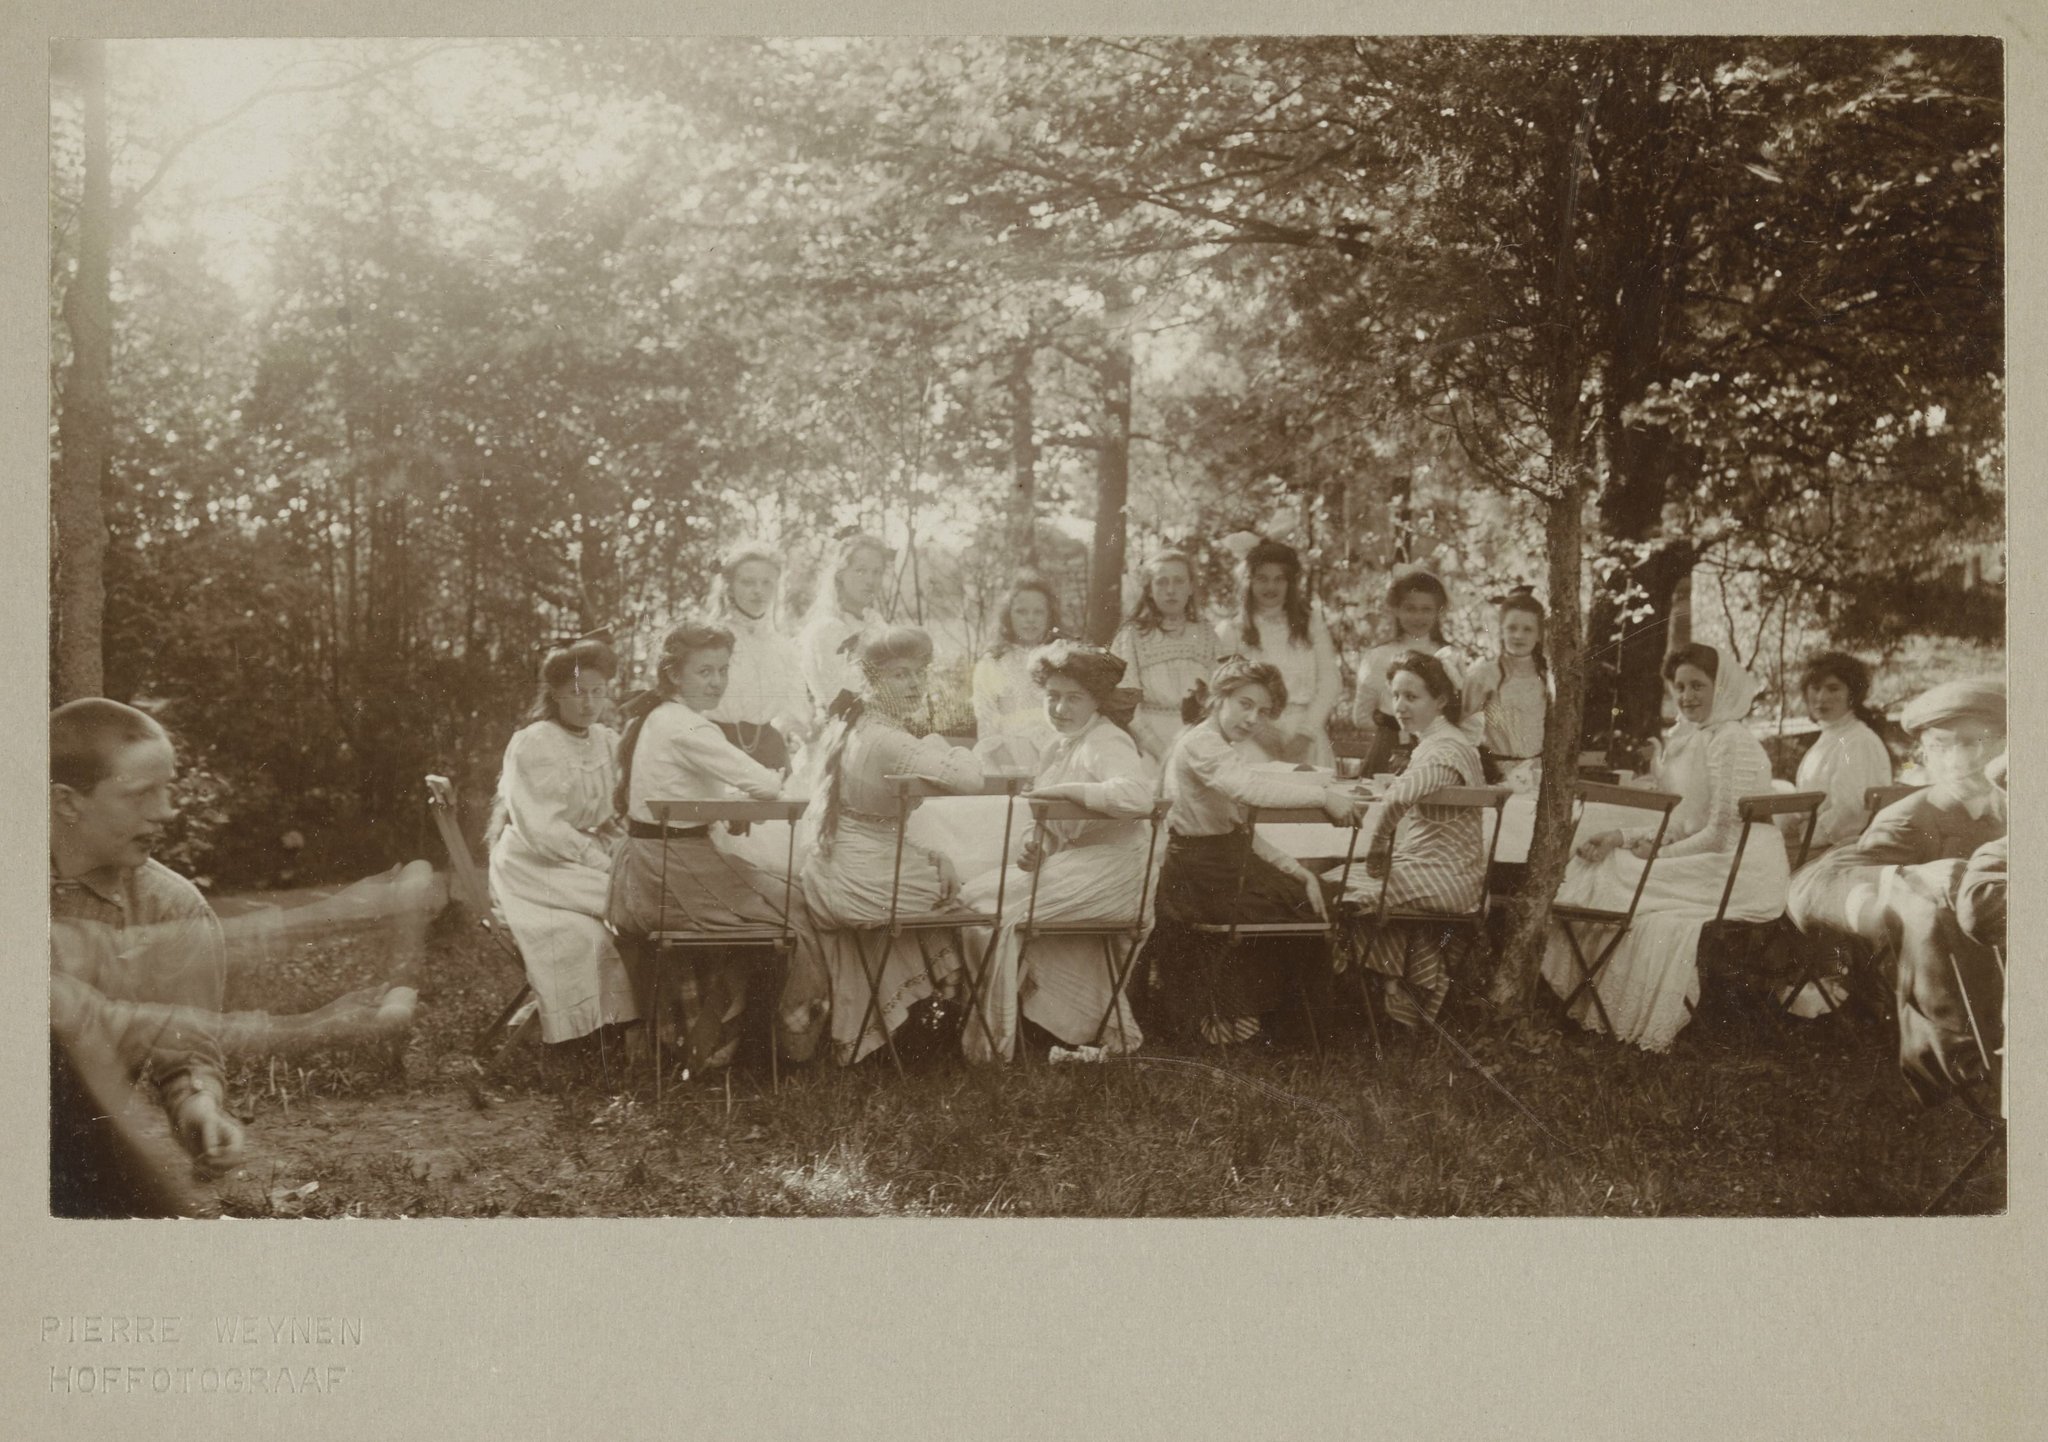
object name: photograph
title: Groepsportret van onbekende jonge vrouwen aan tafel in een bos of park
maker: pierre weijnen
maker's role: fotograaf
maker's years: 1861-1933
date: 1900-1915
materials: paper, cardboard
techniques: collodion silver print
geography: netherlands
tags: adolescent, young woman, maiden, forest, wood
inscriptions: inscription: ‘2. [...]’, check stamp: ‘PIERRE WEYNEN/ HOFFOTOGRAAF’